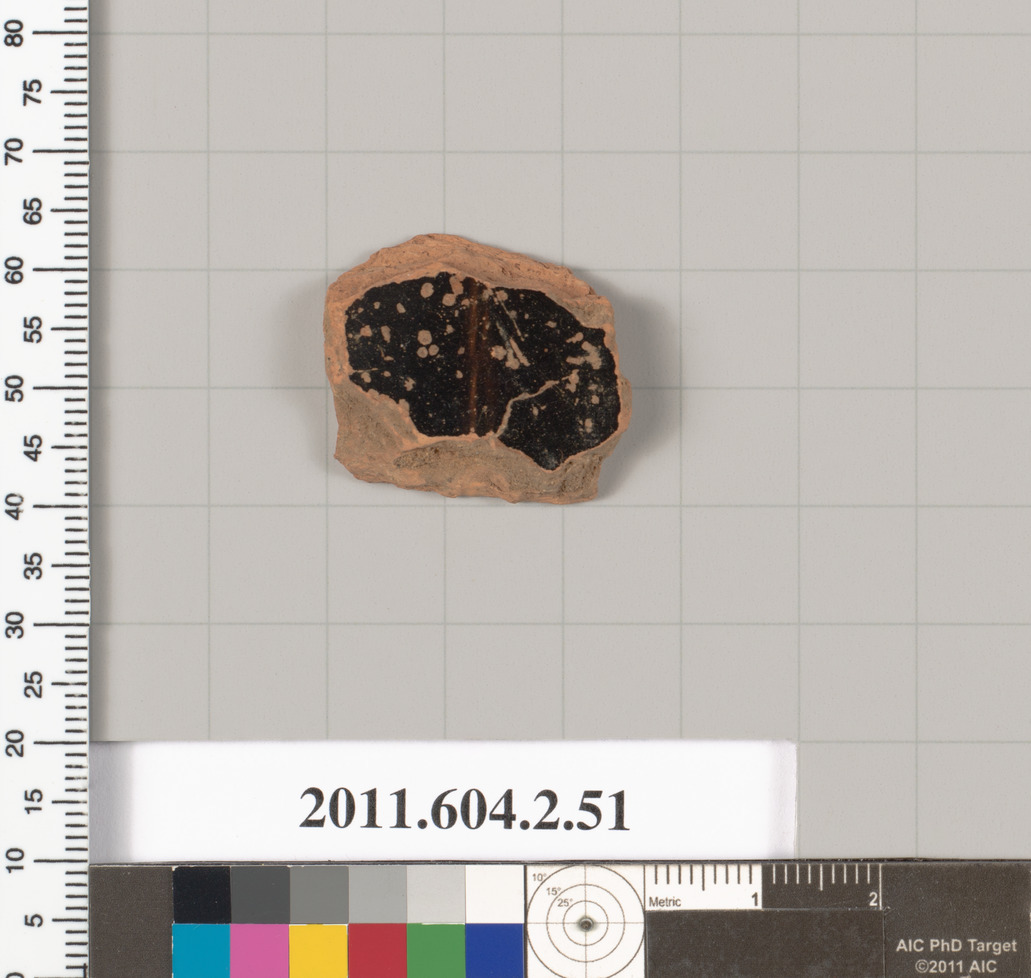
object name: pelike fragment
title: Terracotta fragment of a pelike (jar)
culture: greek, attic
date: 510-480 BCE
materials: terracotta